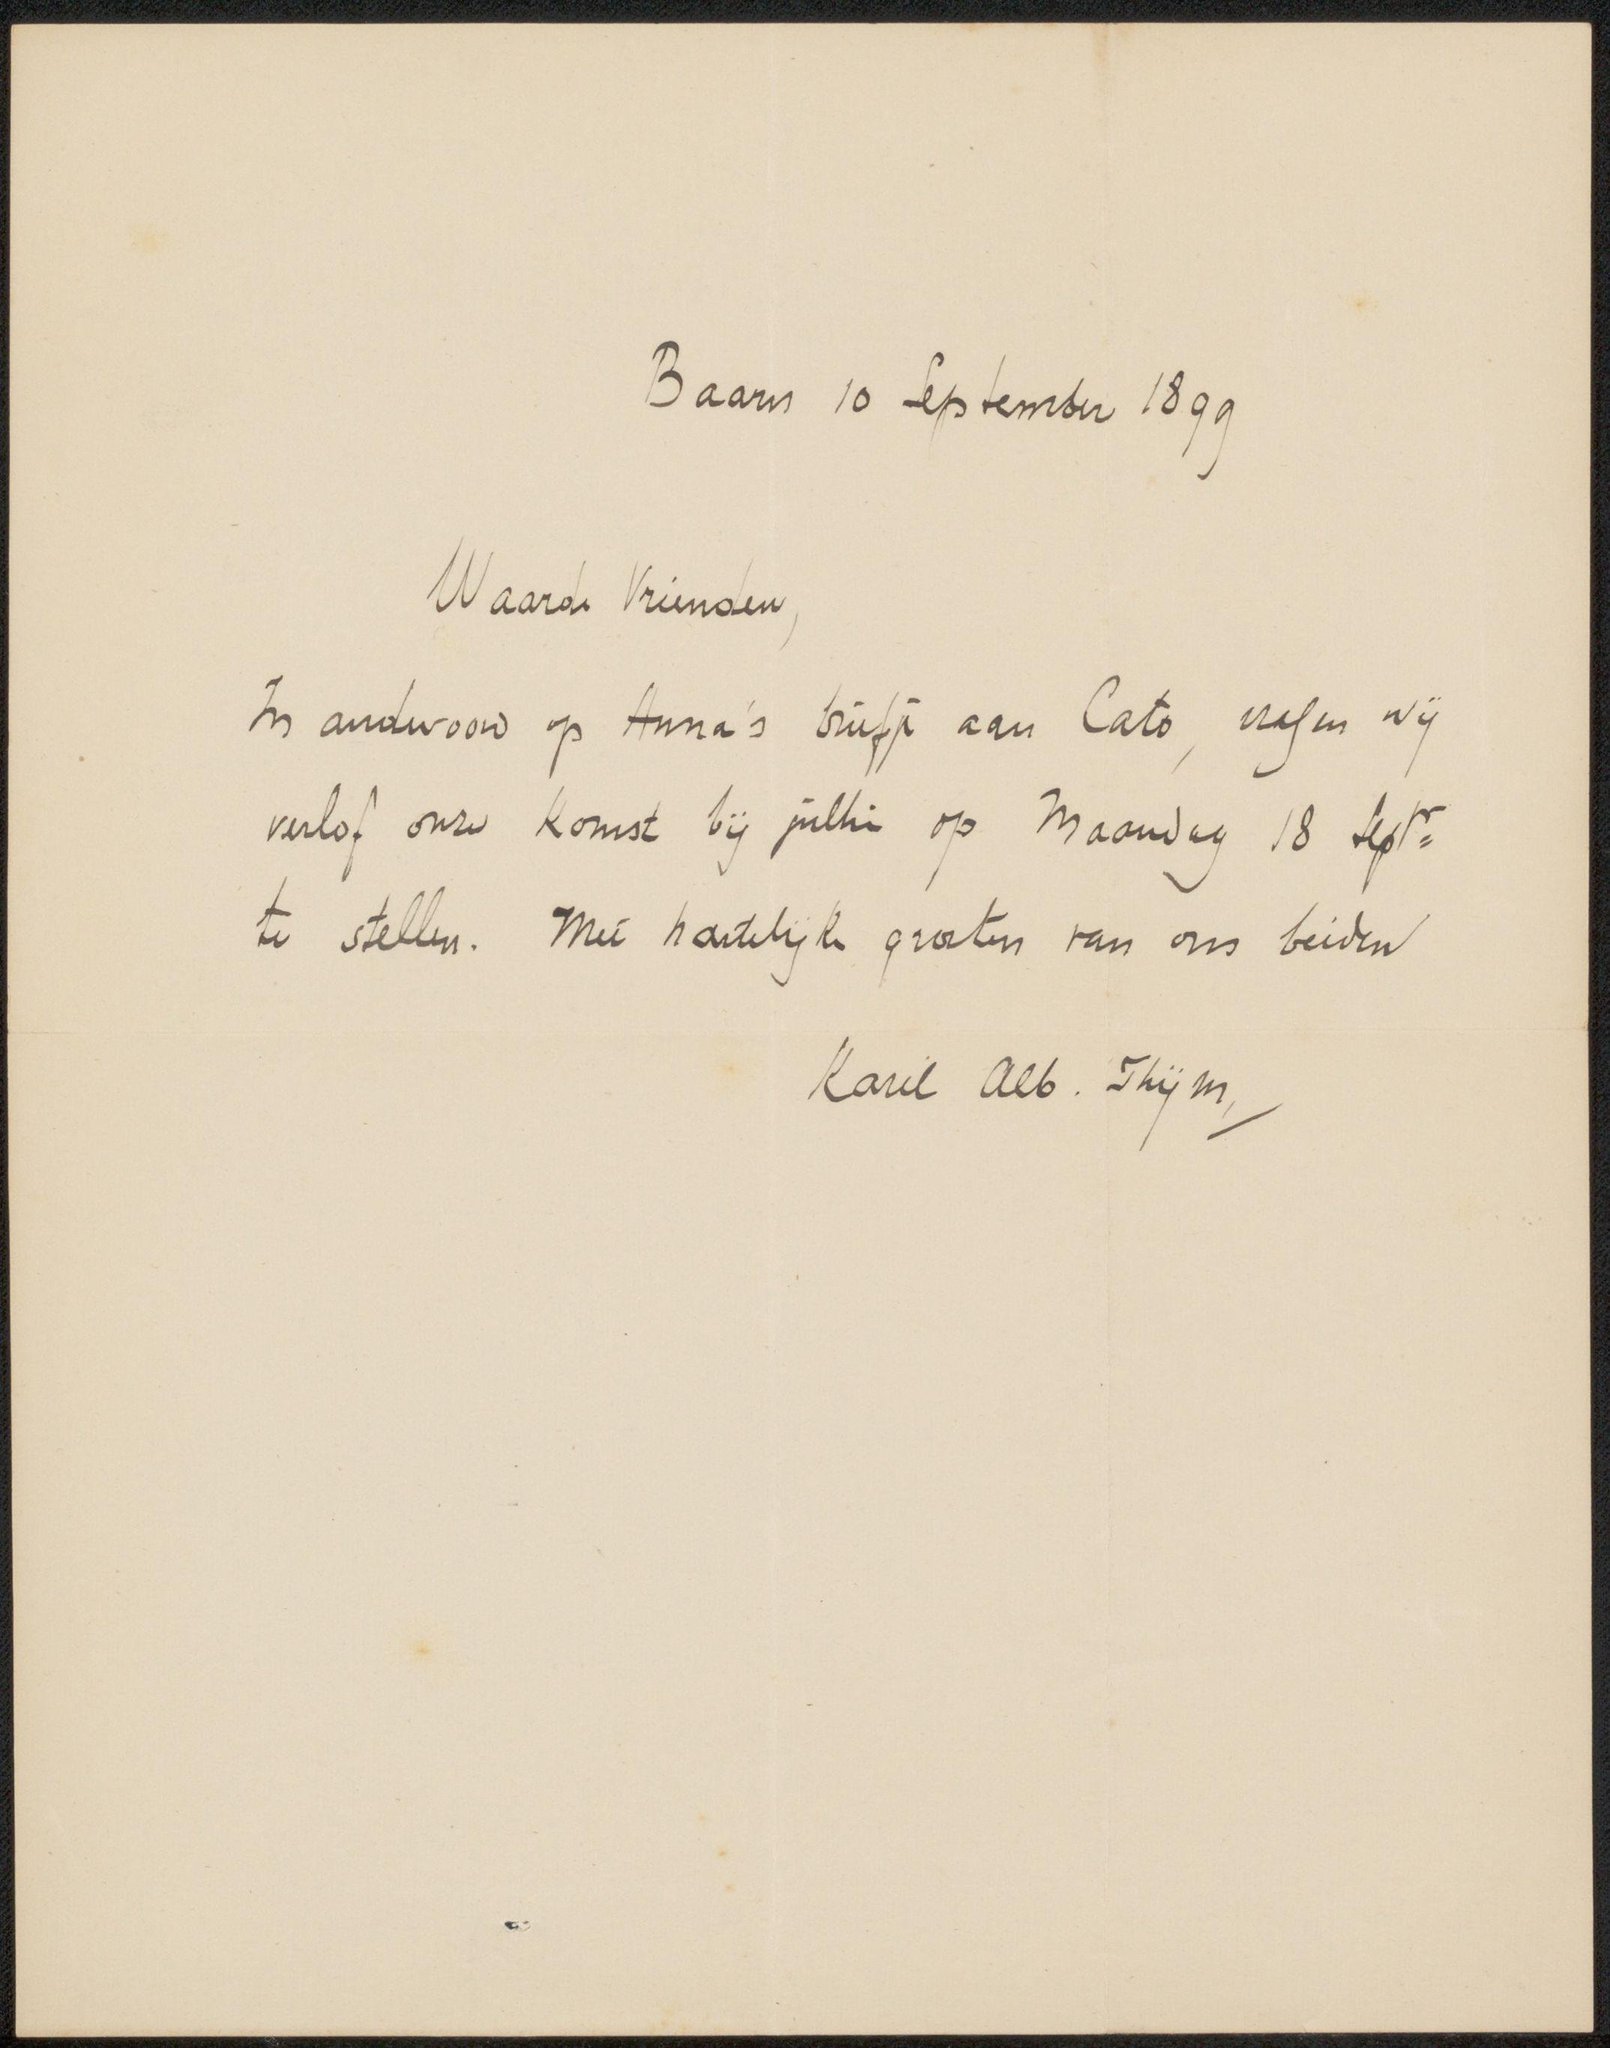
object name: letter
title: Brief aan Jan Veth en Anna Dorothea Dirks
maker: karel johan lodewijk alberdingk thijm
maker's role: criticus, prozaschrijver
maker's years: 1864-1952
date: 1899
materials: ink, paper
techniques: pen, writing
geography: baarn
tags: dordrecht, painter, print maker, draughtsman, designer, jan veth, artist, anna dorothea dirks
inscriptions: collector's mark: ‘RPK’